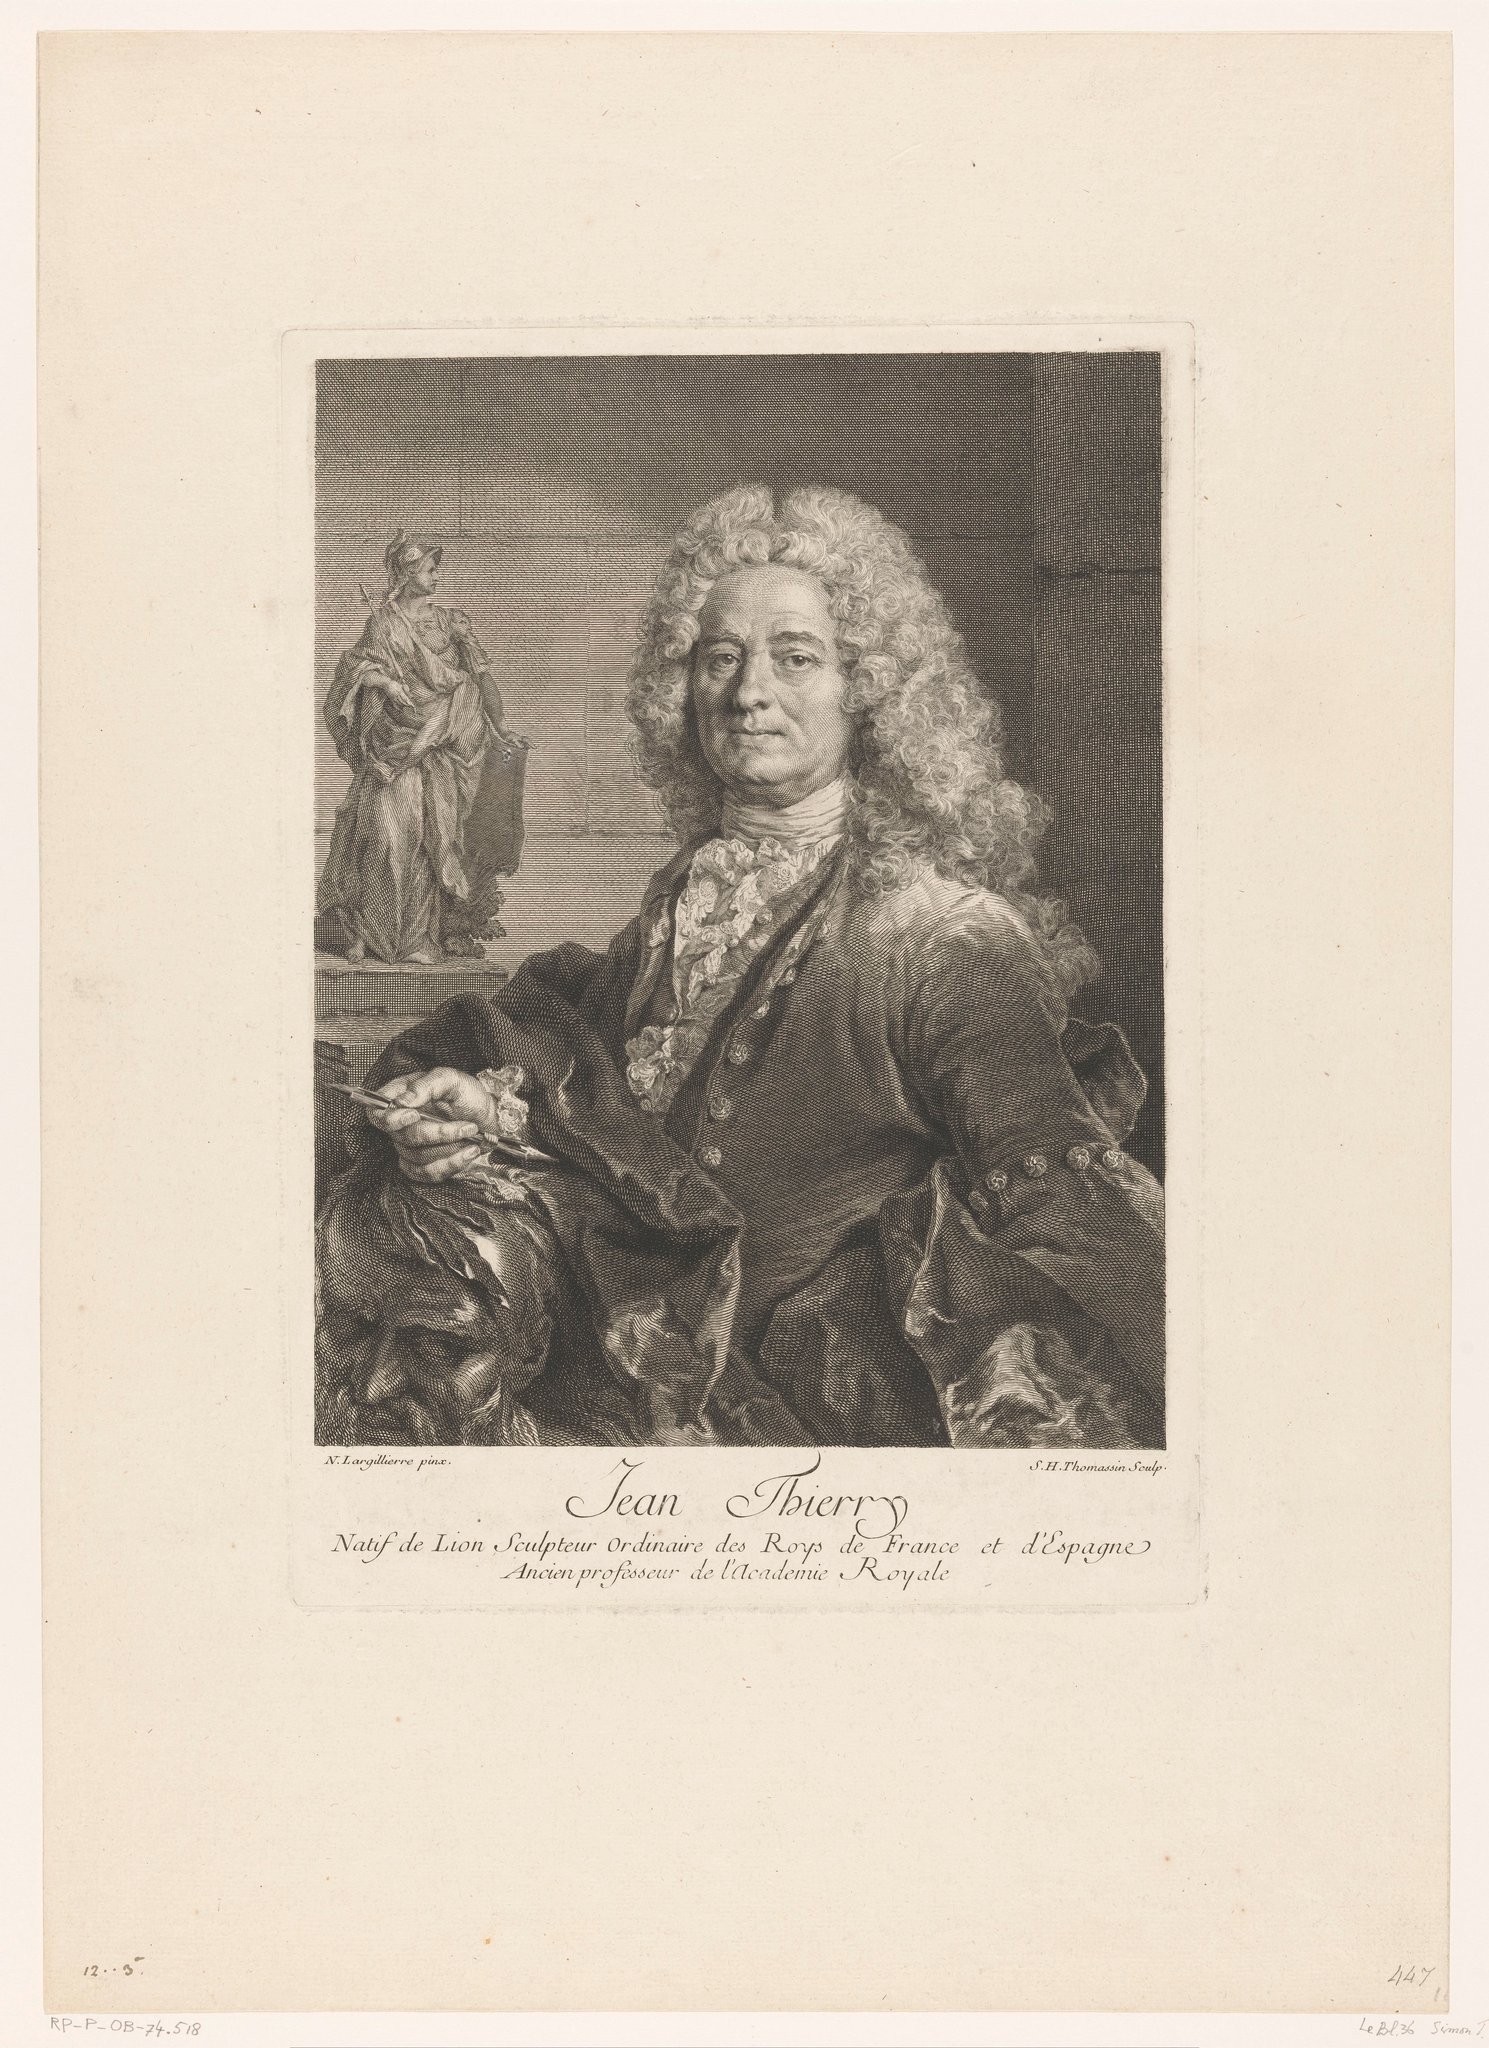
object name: print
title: Portret van Jean Thierry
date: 1697-1741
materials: paper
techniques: engraving, etching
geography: france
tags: lyon, sculptor, jean thierry, portrait, self-portrait of sculptor, historical persons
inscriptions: collector's mark: Lugt 240, number: ‘D 2338’, number: ‘12..3’